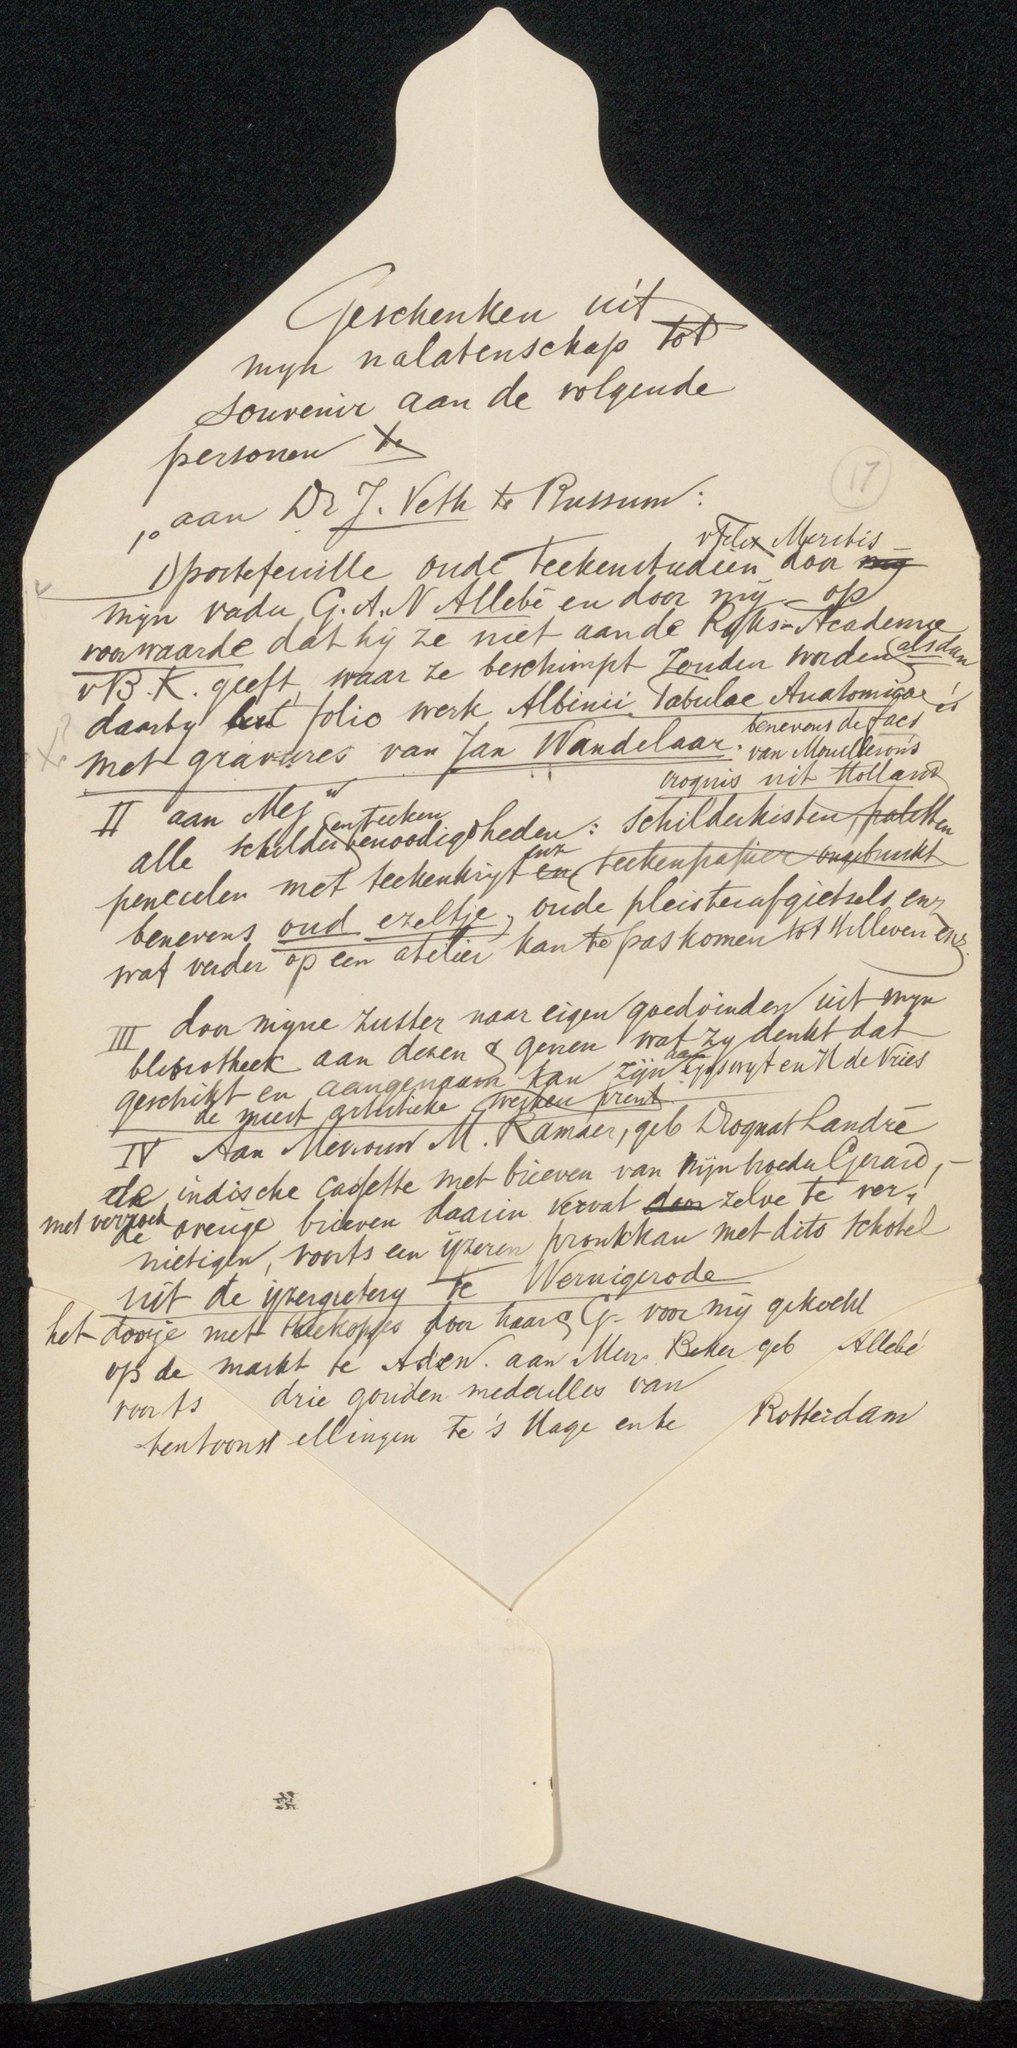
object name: envelope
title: Aantekening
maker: august allebé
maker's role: draughtsman, print maker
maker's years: 1838-1927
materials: ink, paper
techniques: pen, writing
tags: dordrecht, painter, designer, jan veth, agnieta cornelia gijswijt, henriëtte de vries, amsterdam, leiden, print maker, draughtsman, jan wandelaar, drawing, the graphic arts, painting (including book-illumination, miniature-painting), exhibition ~ art, printed matter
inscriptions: collector's mark: ‘RPK’